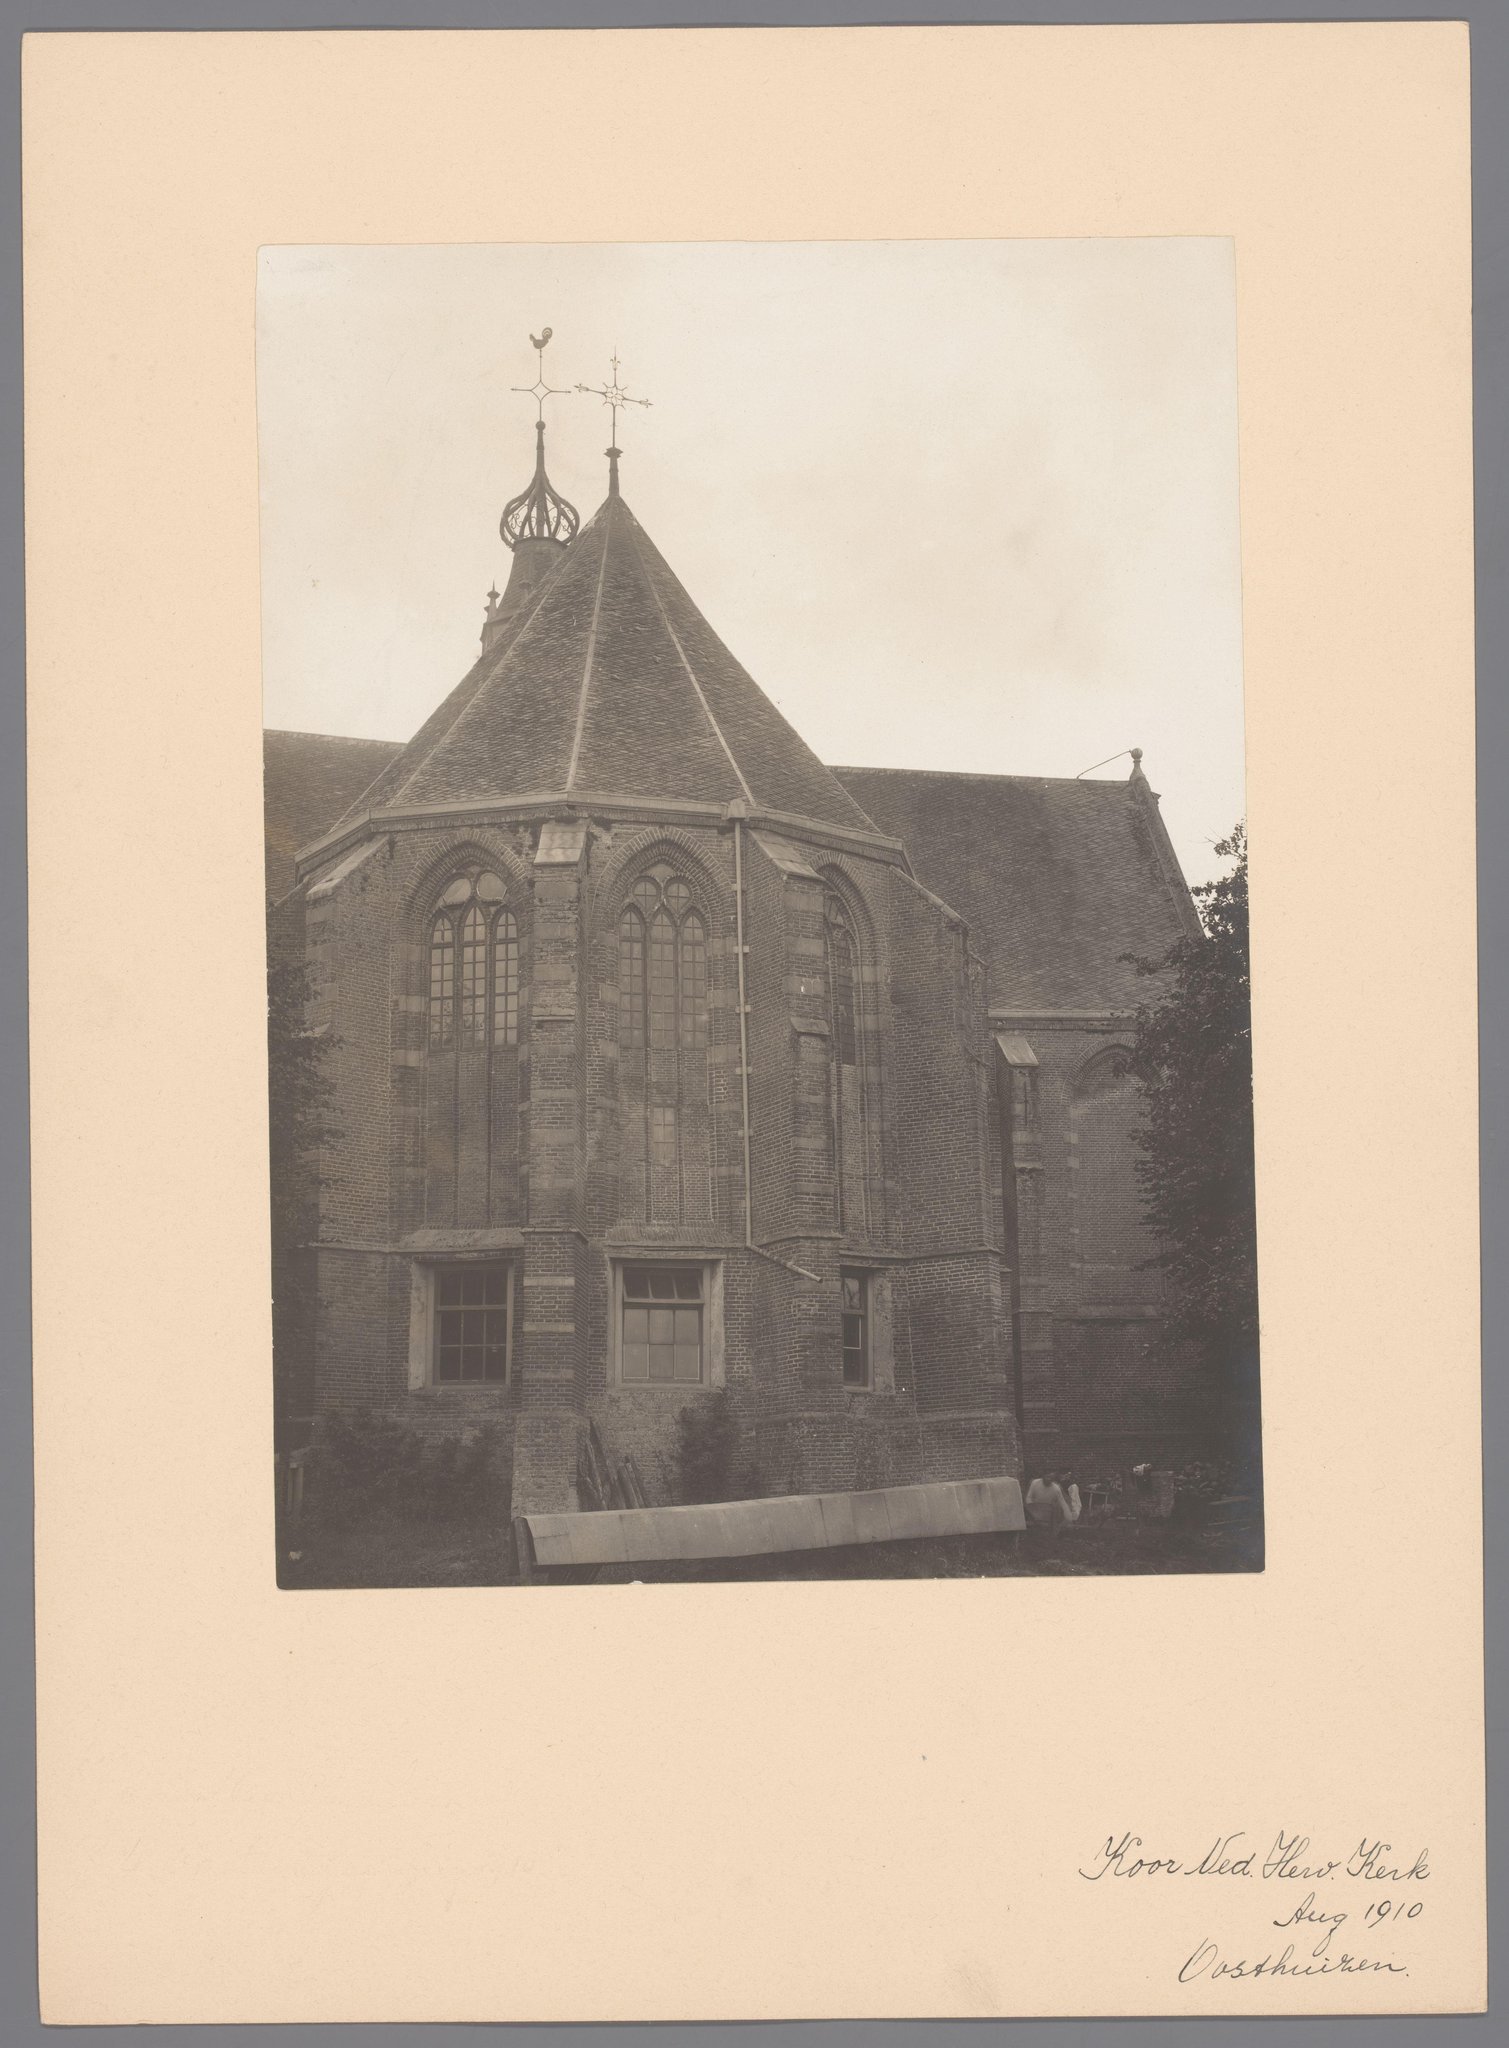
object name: photograph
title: Gezicht op het koor van de Grote Kerk te Oosthuizen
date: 1910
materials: cardboard, photographic support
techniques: gelatin silver print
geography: oosthuizen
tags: church (exterior)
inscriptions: annotation: ‘Koor Ned. Herv. Kerk/ Aug 1910/ Oosthuizen’